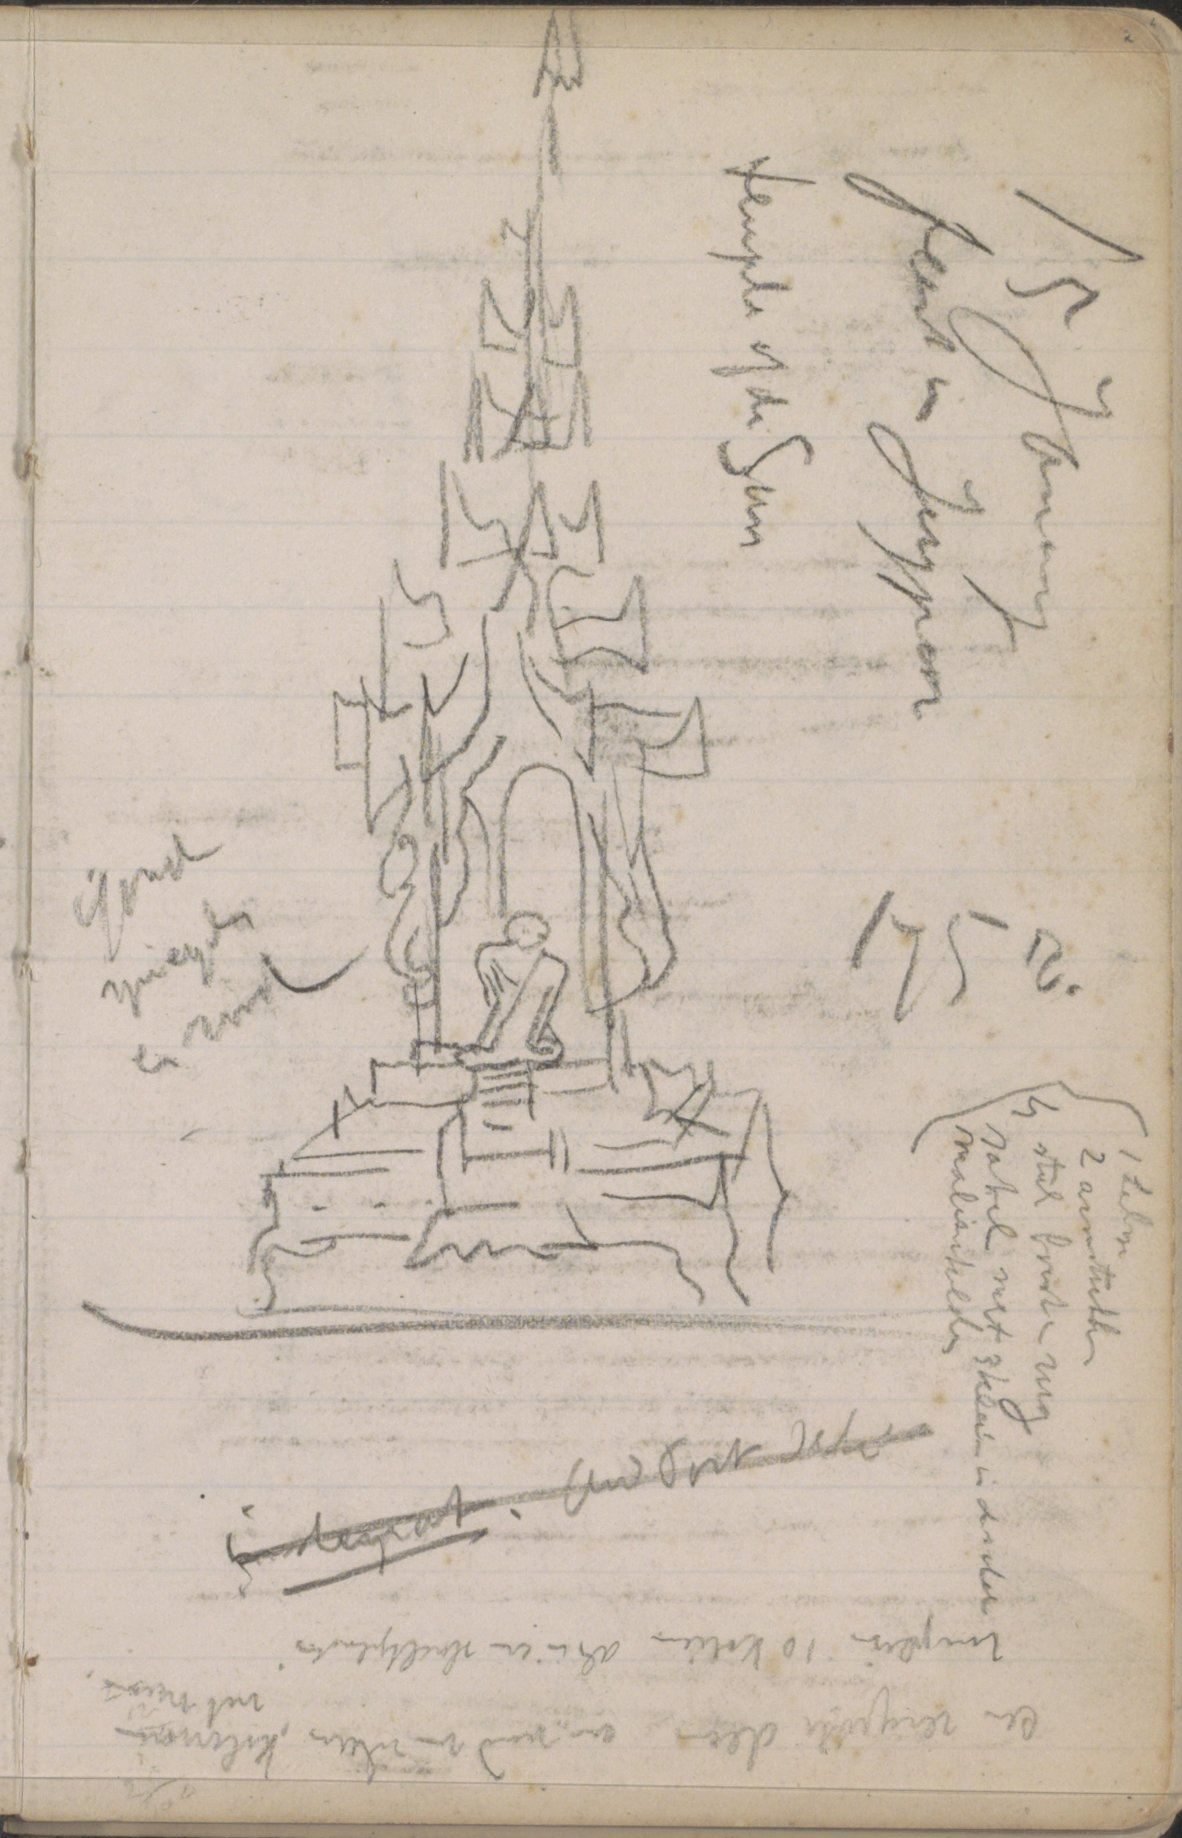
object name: sketchbook leaf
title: Hindoeïstisch monument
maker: marius bauer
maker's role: draughtsman, print maker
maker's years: 1867-1932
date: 1897-1898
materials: pencil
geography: india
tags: temple, shrine ~ hinduism, buddhism, jainism, statues, paintings, etc. ~ objects of worship (hinduism, buddhism, jainism)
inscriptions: annotation: ‘15 January/ tent in Jeypor/ temple of de sun/ [...] goud/ spiegels/ en rood/ 1 helm/ [...]’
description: Mogelijk een plaats van aanbidding. Een beeldhouwwerk, vermoedelijk van een godheid, heeft een prominente plek op het bouwwerk. Pagina 2 uit een schetsboek met 84 bladen.